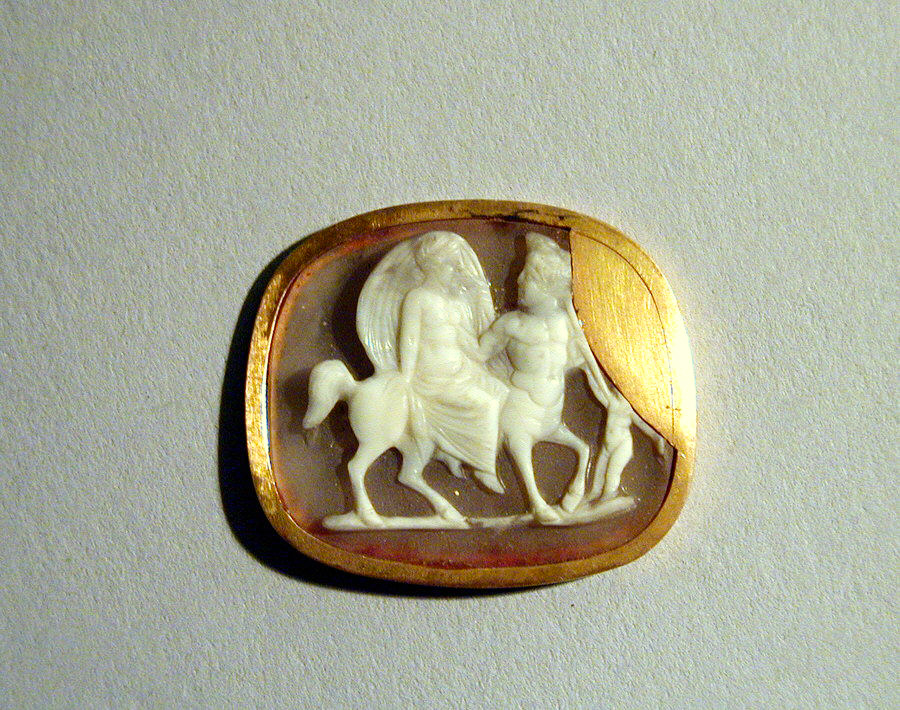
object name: cameo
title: Sardonyx cameo of a nymph riding a centaur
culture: greek or roman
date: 100 BCE-100 CE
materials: gemstone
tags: centaurs,nymphs